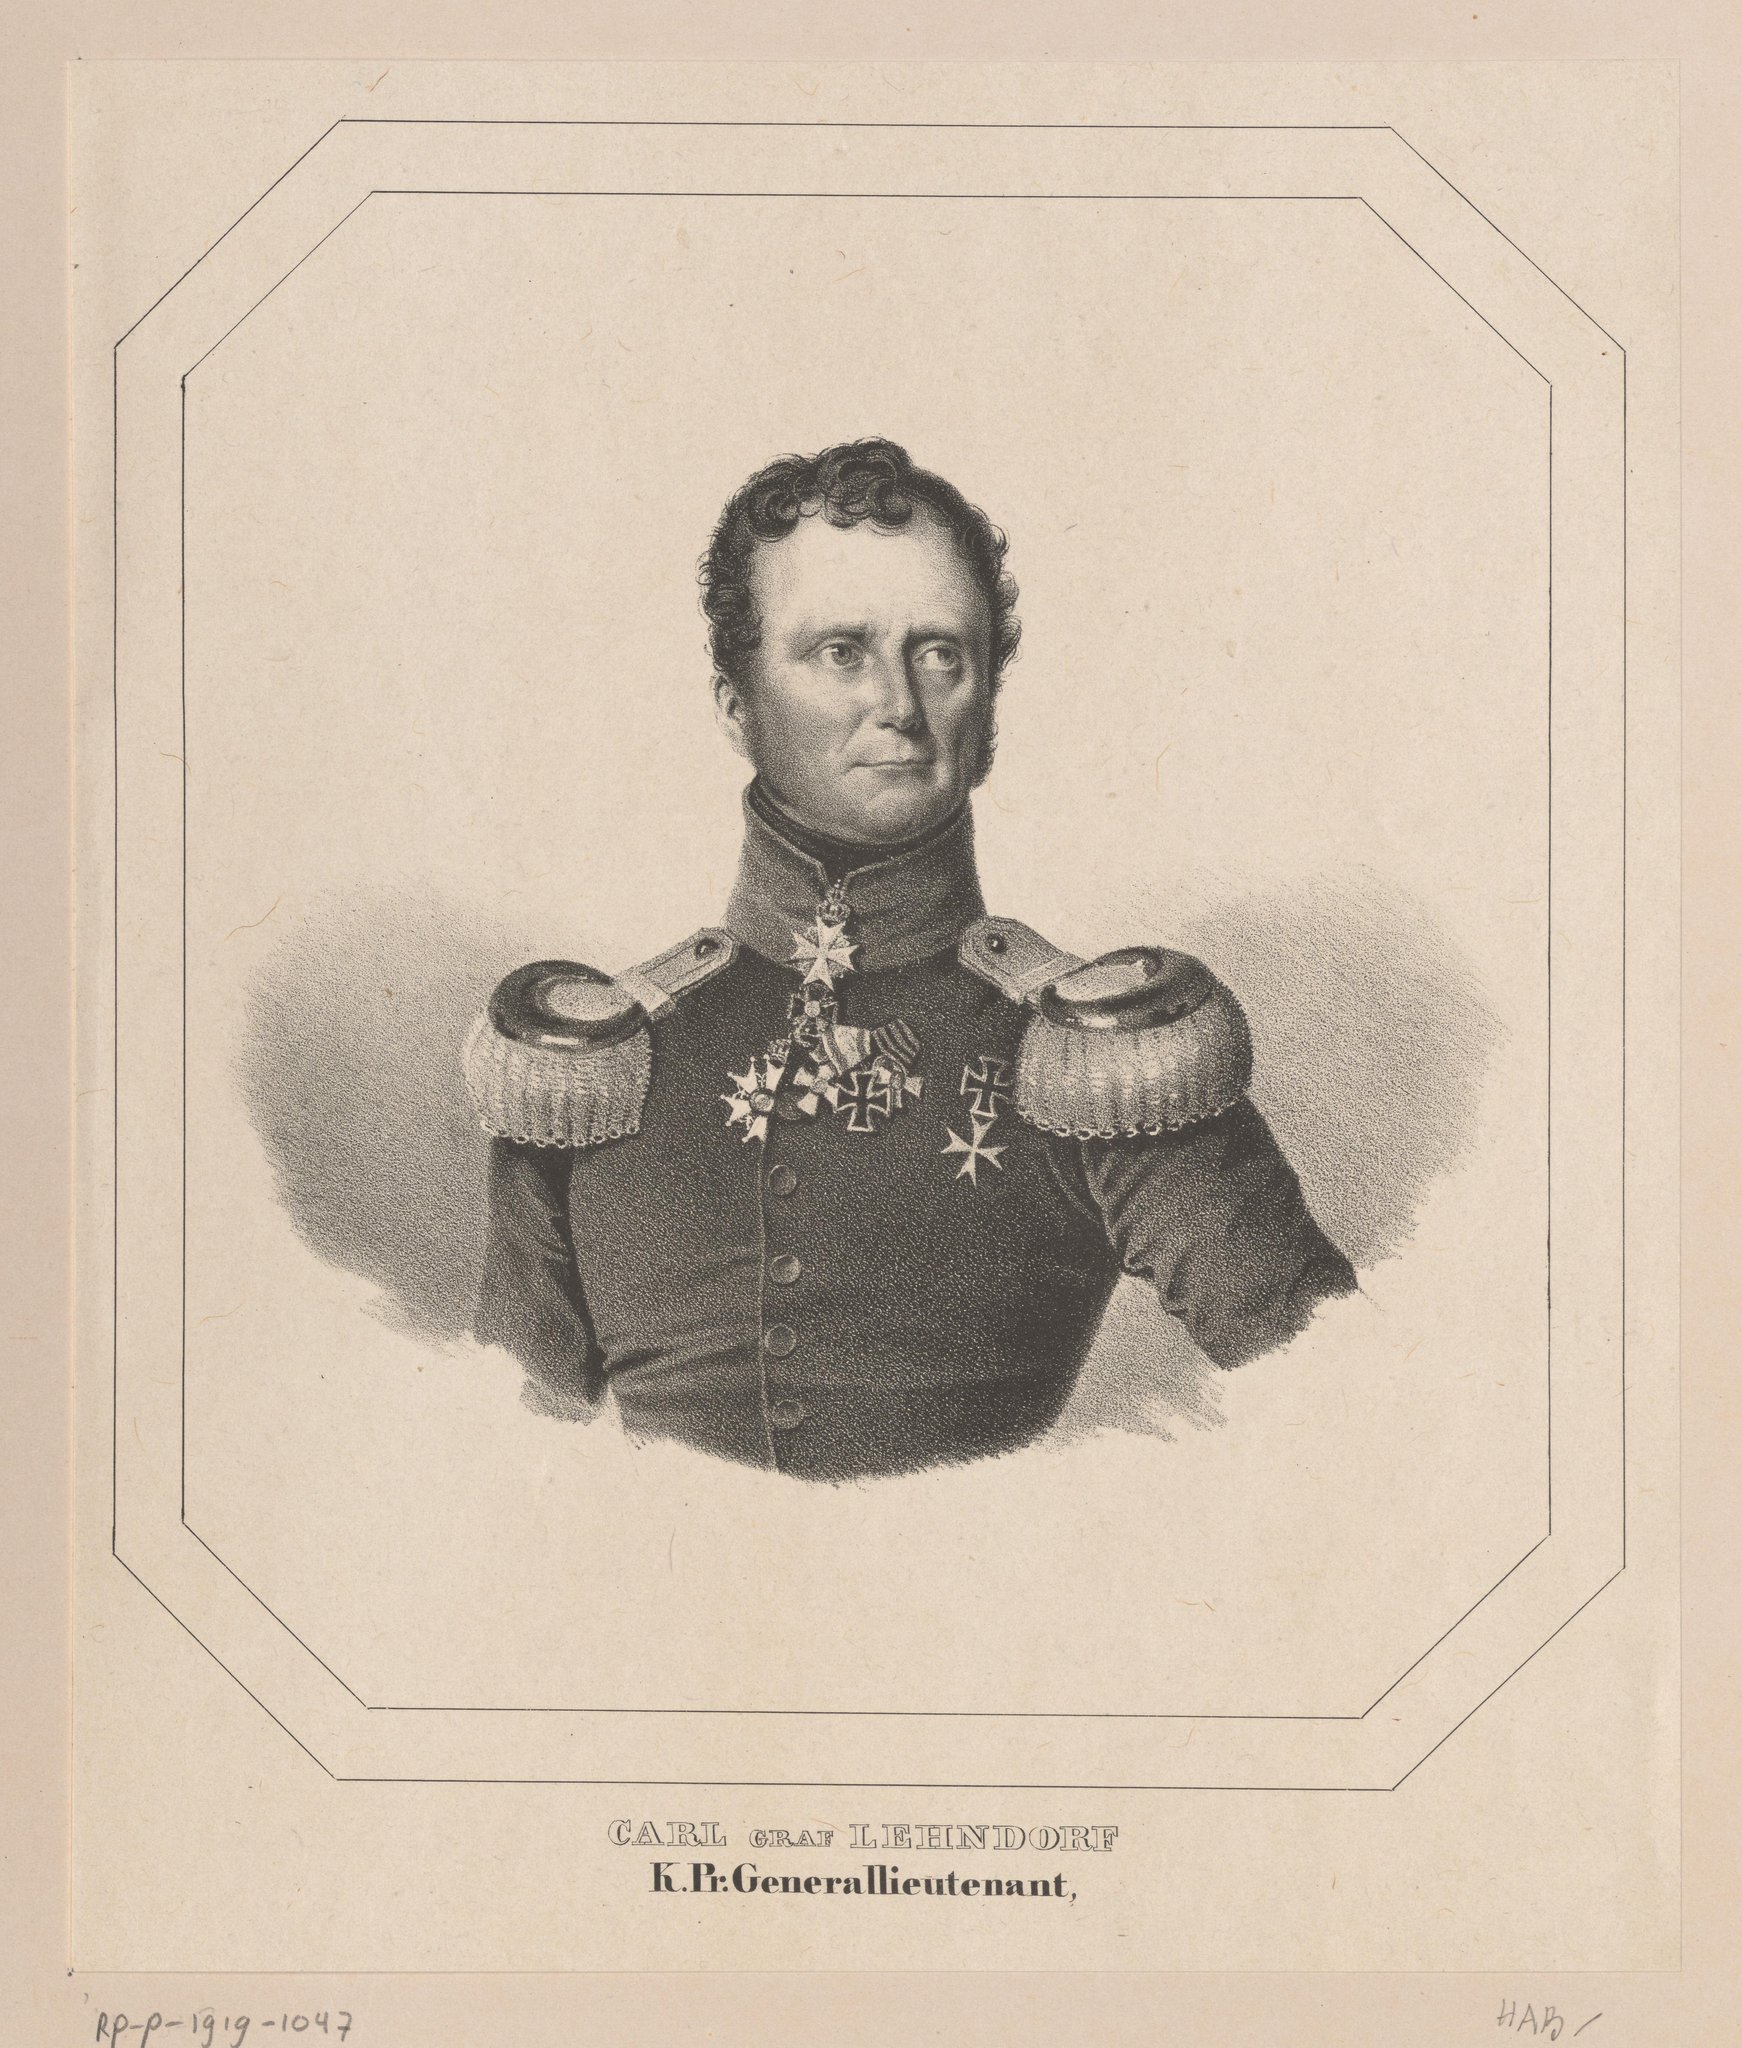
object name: print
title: Portret van Karl von Lehndorff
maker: Anonymous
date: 1810-1899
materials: paper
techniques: lithograph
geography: germany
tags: commander-in-chief, general, marshal, historical persons, (military) uniforms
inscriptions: collector's mark: Lugt 2228